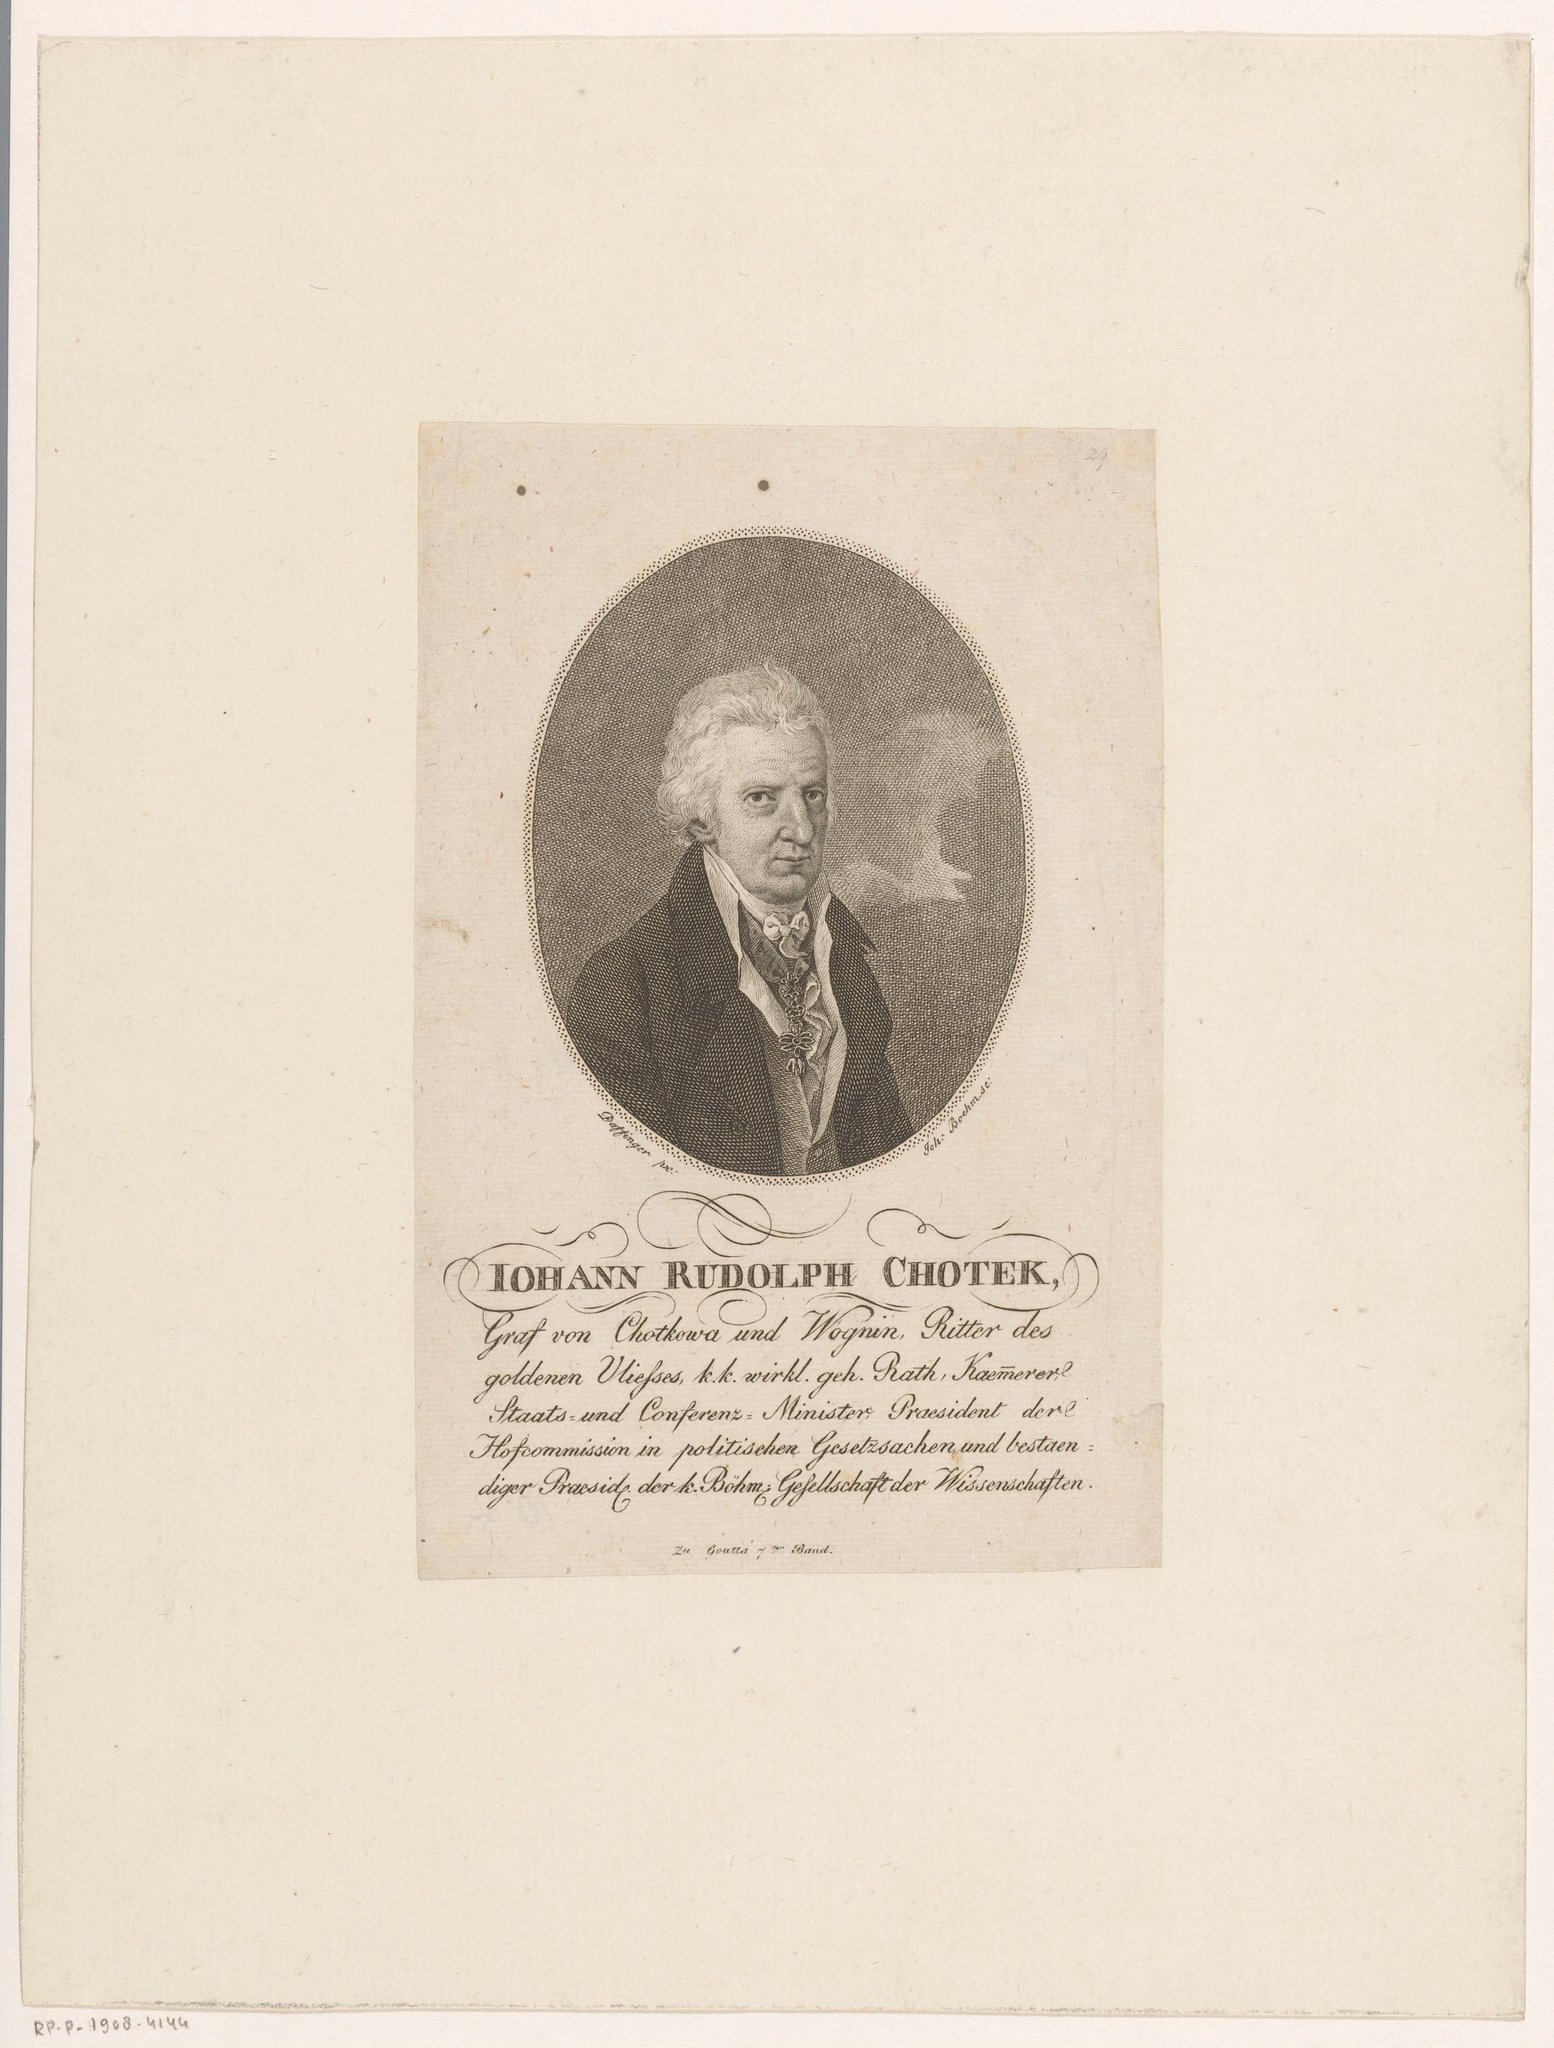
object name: print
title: Portret van Johann Rudolph Chotek von Chotkow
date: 1809-1821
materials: paper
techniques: engraving, etching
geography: leipzig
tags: vienna, johann rudolph chotek von chotkow, historical persons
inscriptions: collector's mark: Lugt 2228